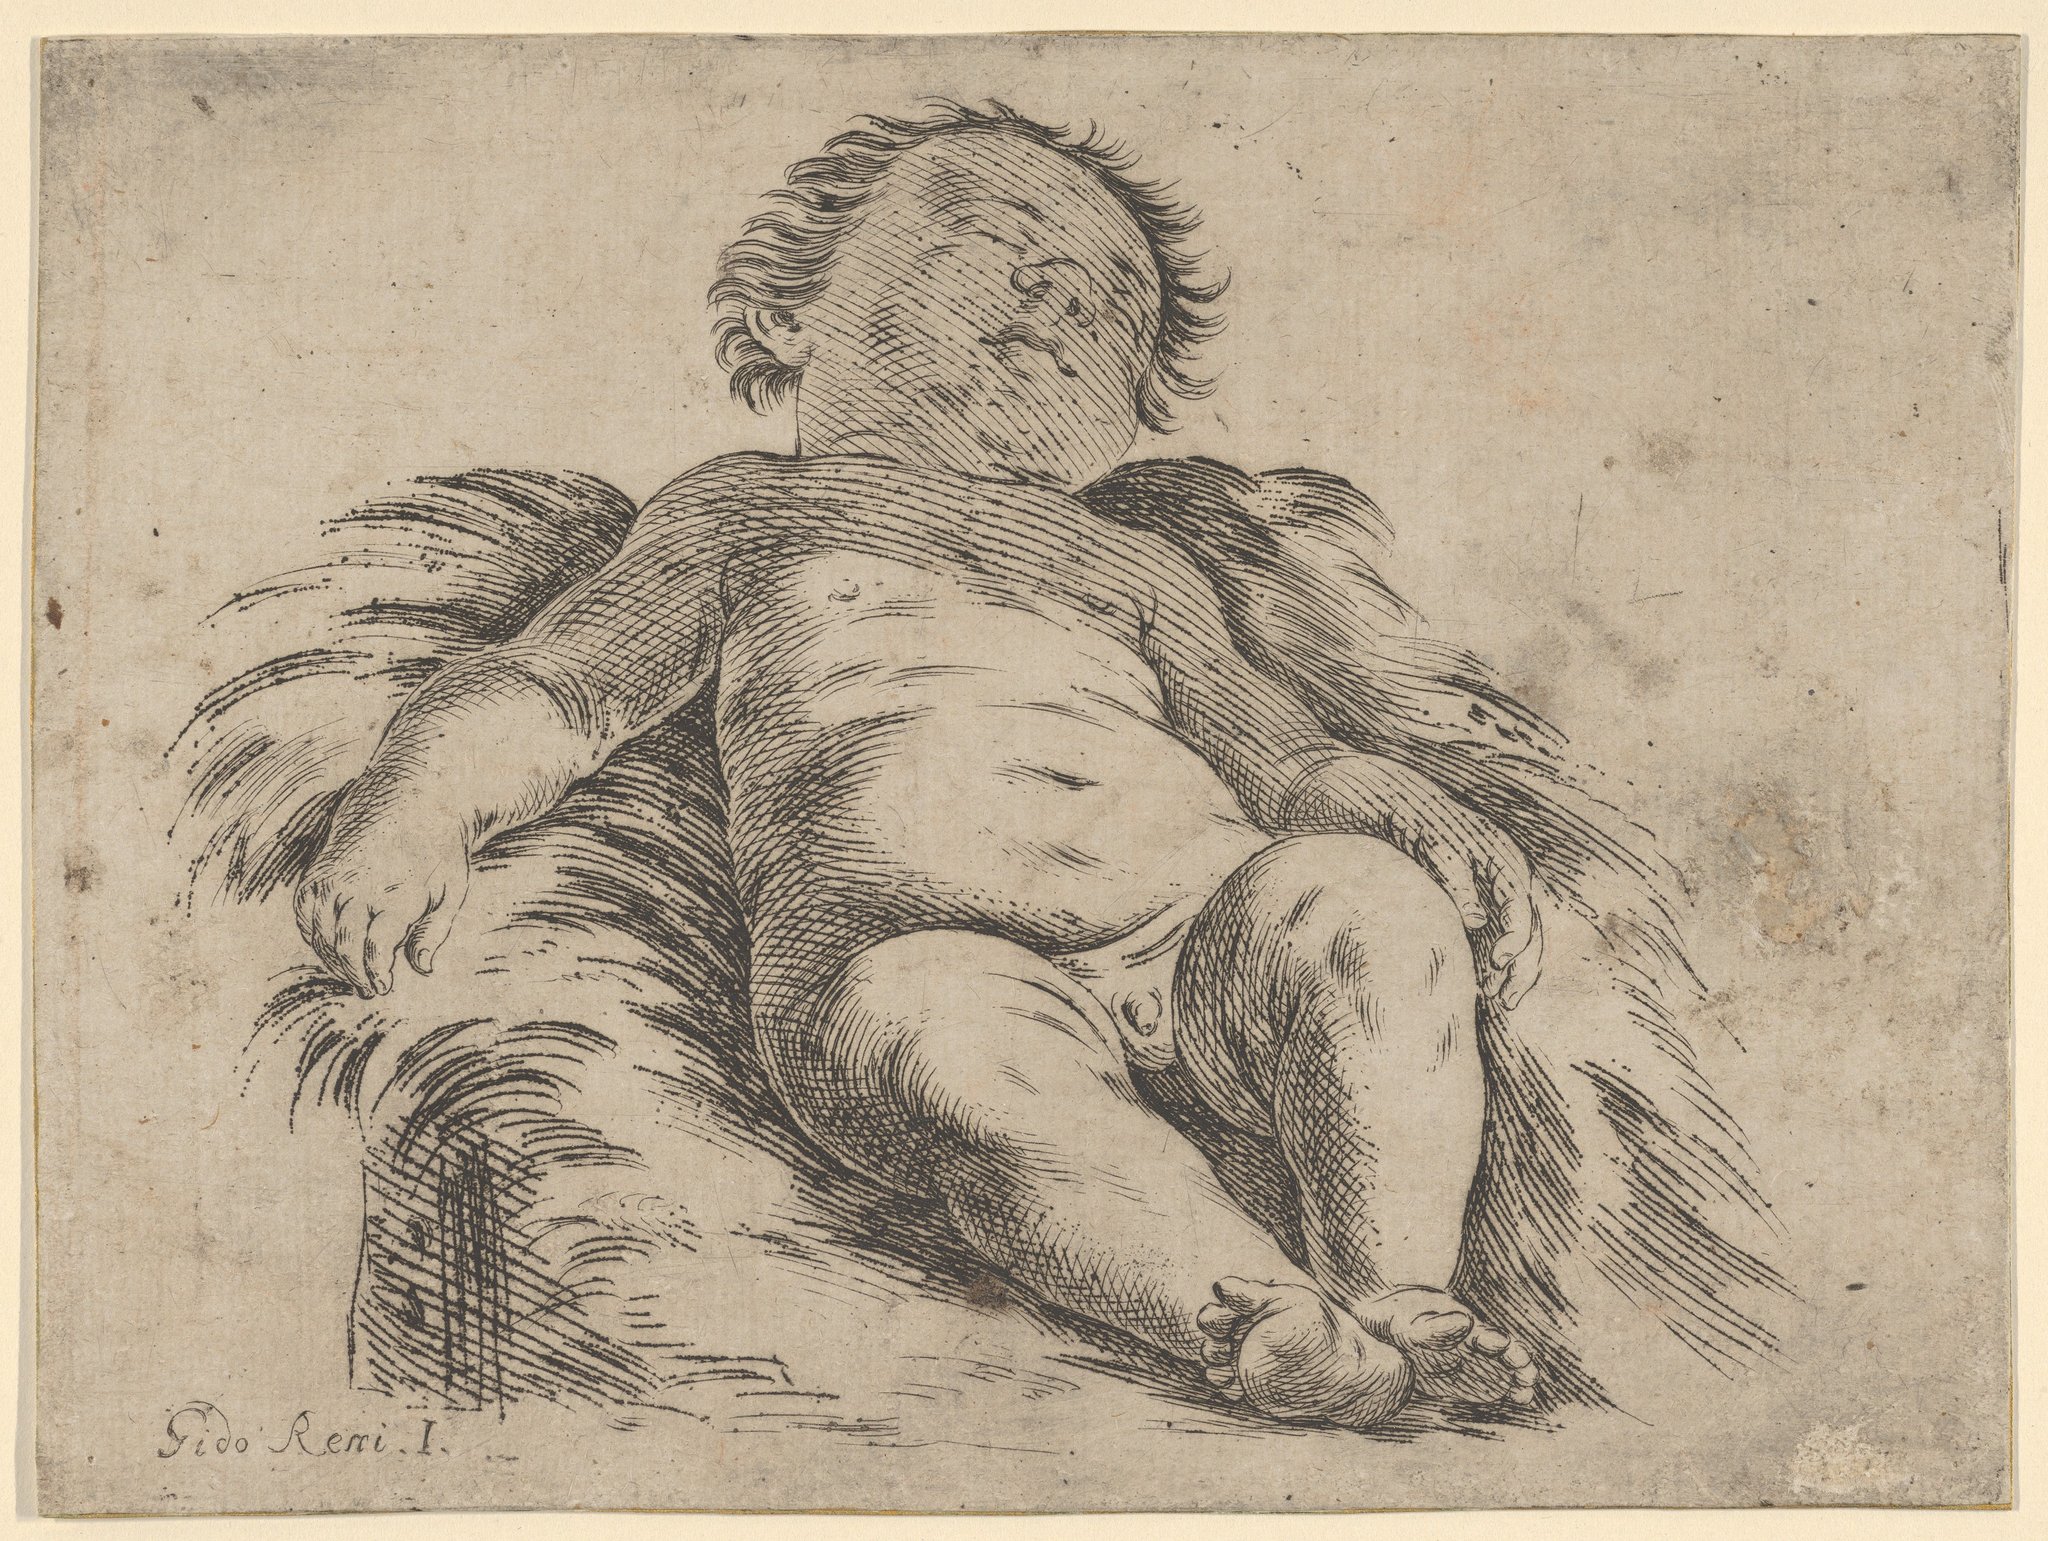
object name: print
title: Sleeping child, partly in shadow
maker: anonymous, 17th century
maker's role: artist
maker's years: 1600-1700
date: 1601-1700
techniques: etching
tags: sleeping,infants